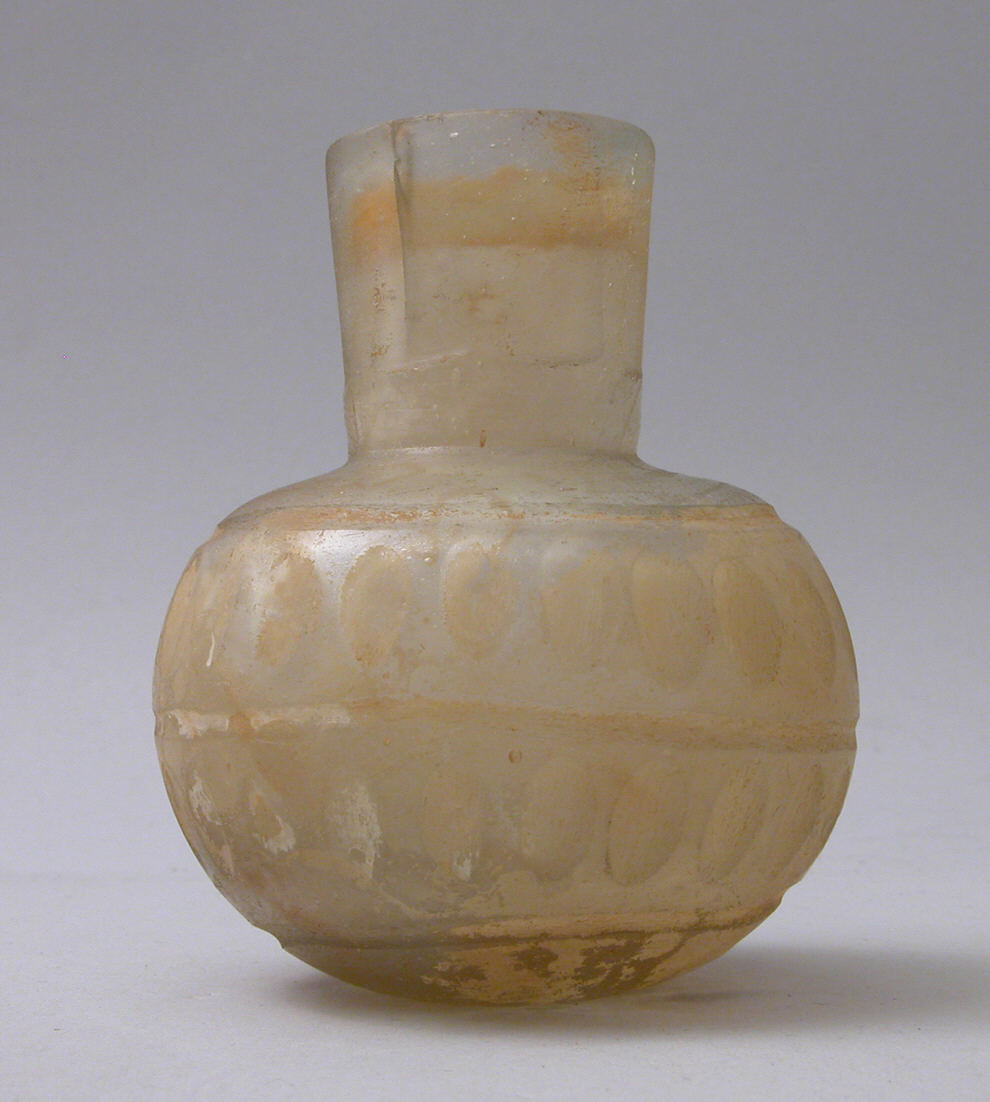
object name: bottle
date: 901-1000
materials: glass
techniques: cutting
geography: iran